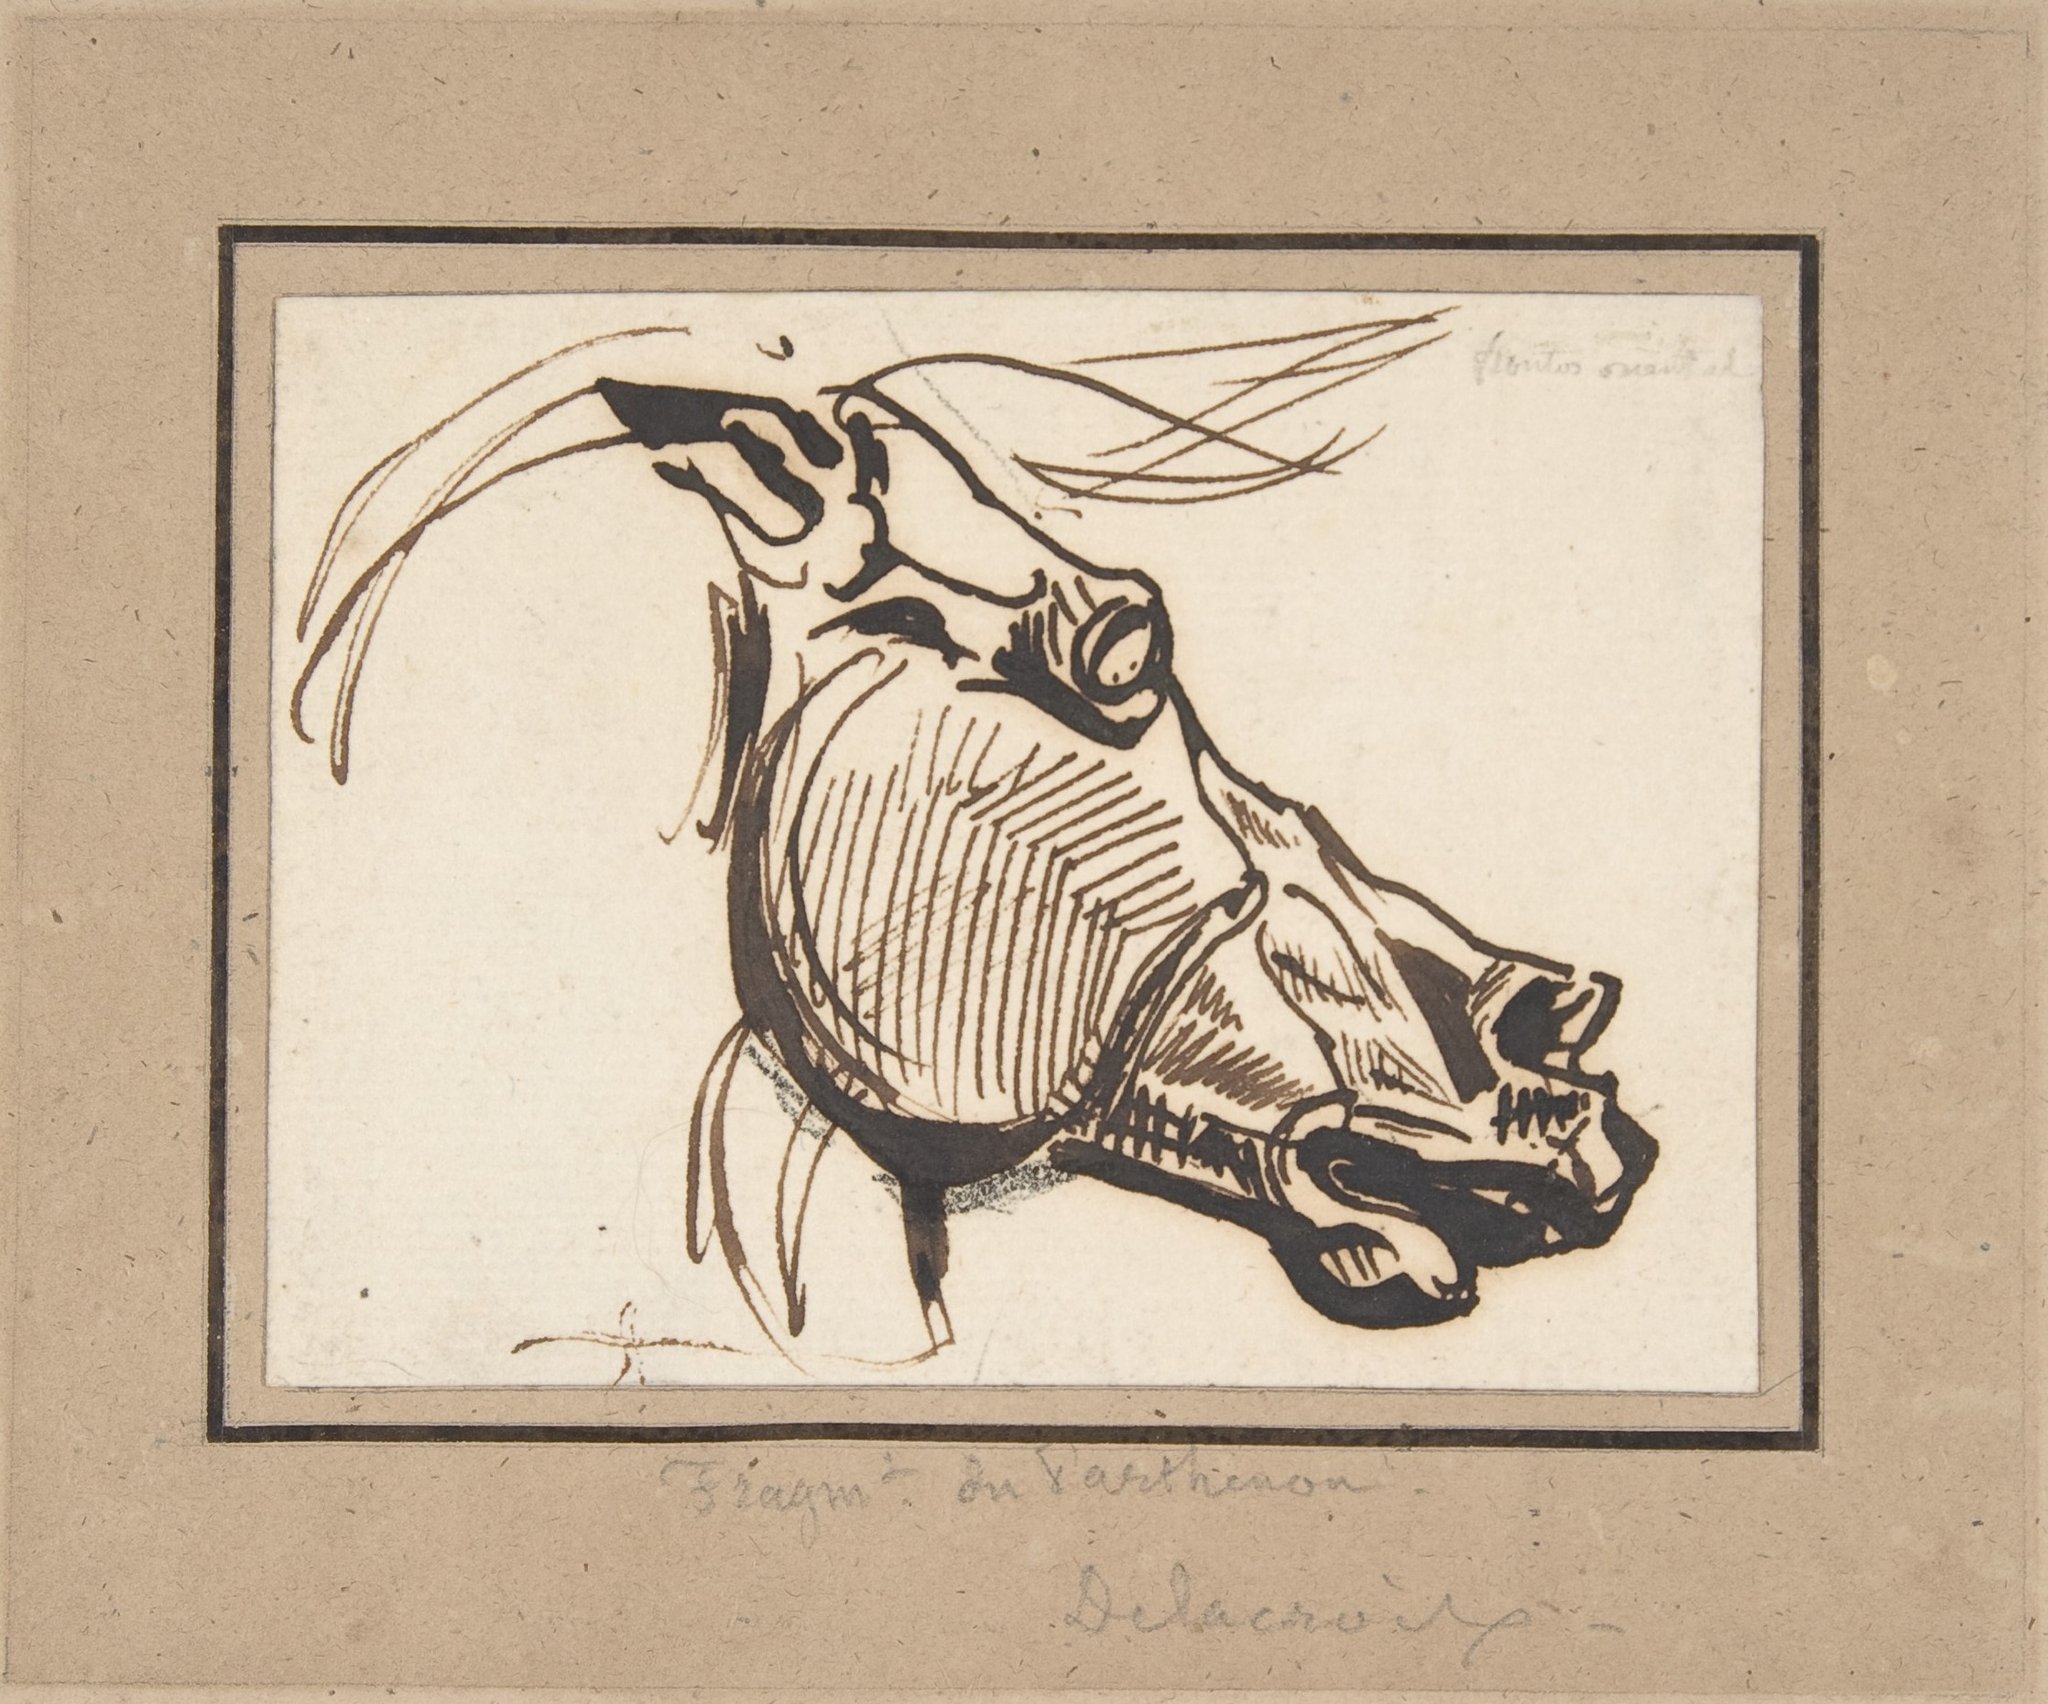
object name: drawing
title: Head of a Horse, after the Parthenon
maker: eugène delacroix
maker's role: artist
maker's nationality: french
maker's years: 1798-1863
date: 1825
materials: chalk, ink, paper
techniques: pen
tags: horses